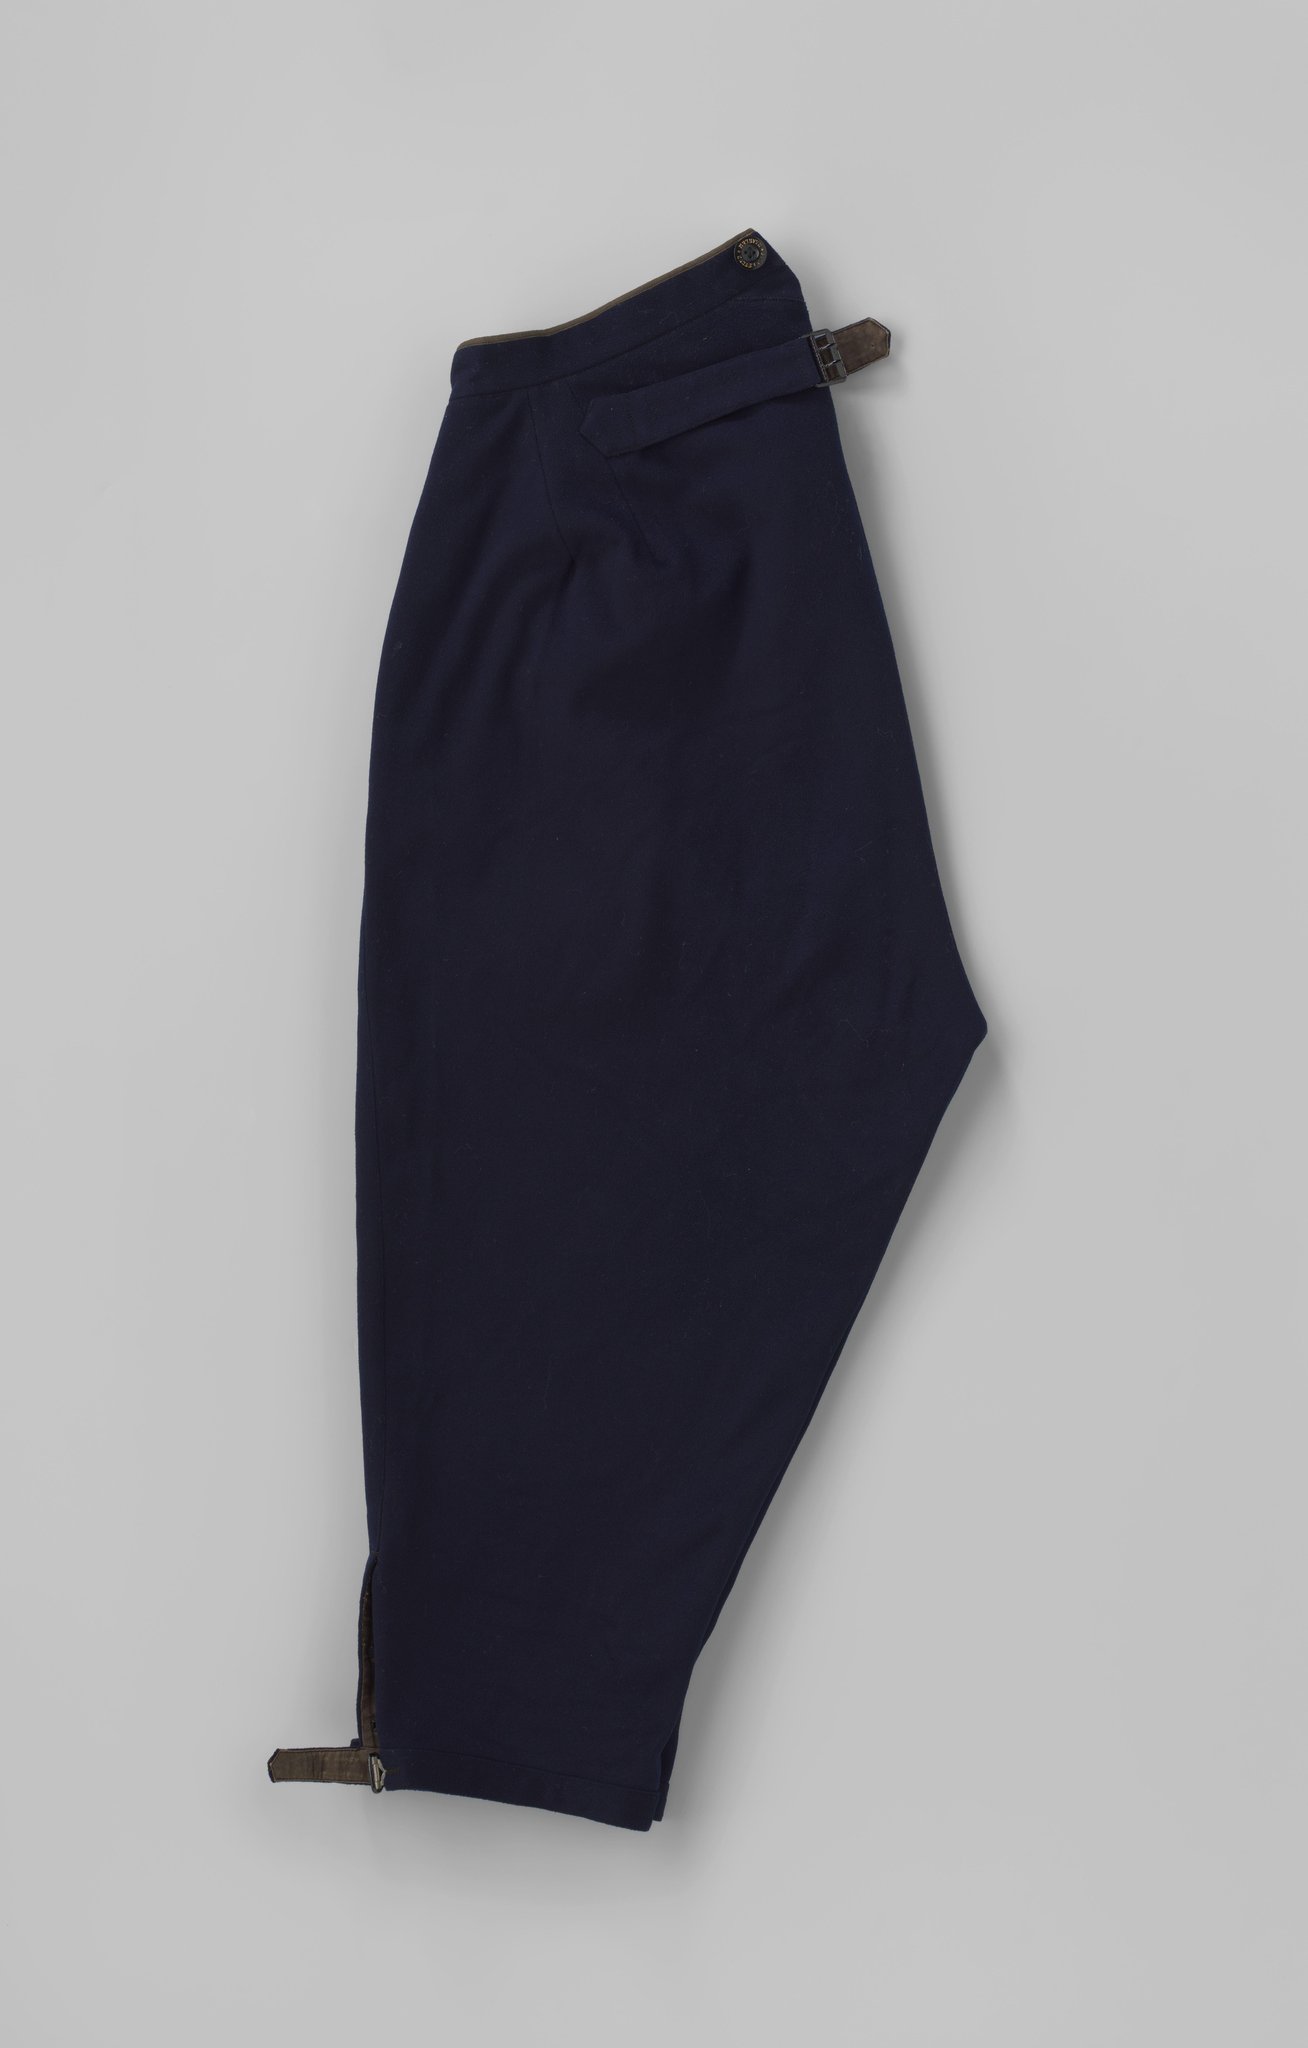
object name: menswear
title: Knechtenbroek met nauwe pijp met sluiting van drie knoopjes en band met gesp van blauw laken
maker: a.j. van der steur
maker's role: kleermaker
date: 1920-1940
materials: textile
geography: haarlem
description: Gemerkt: "A.J. van der Steur"/48 Grote Houtstraat Haarlem" en in handschrift: "Jh. H. Gevers, knecht, nr. 856".